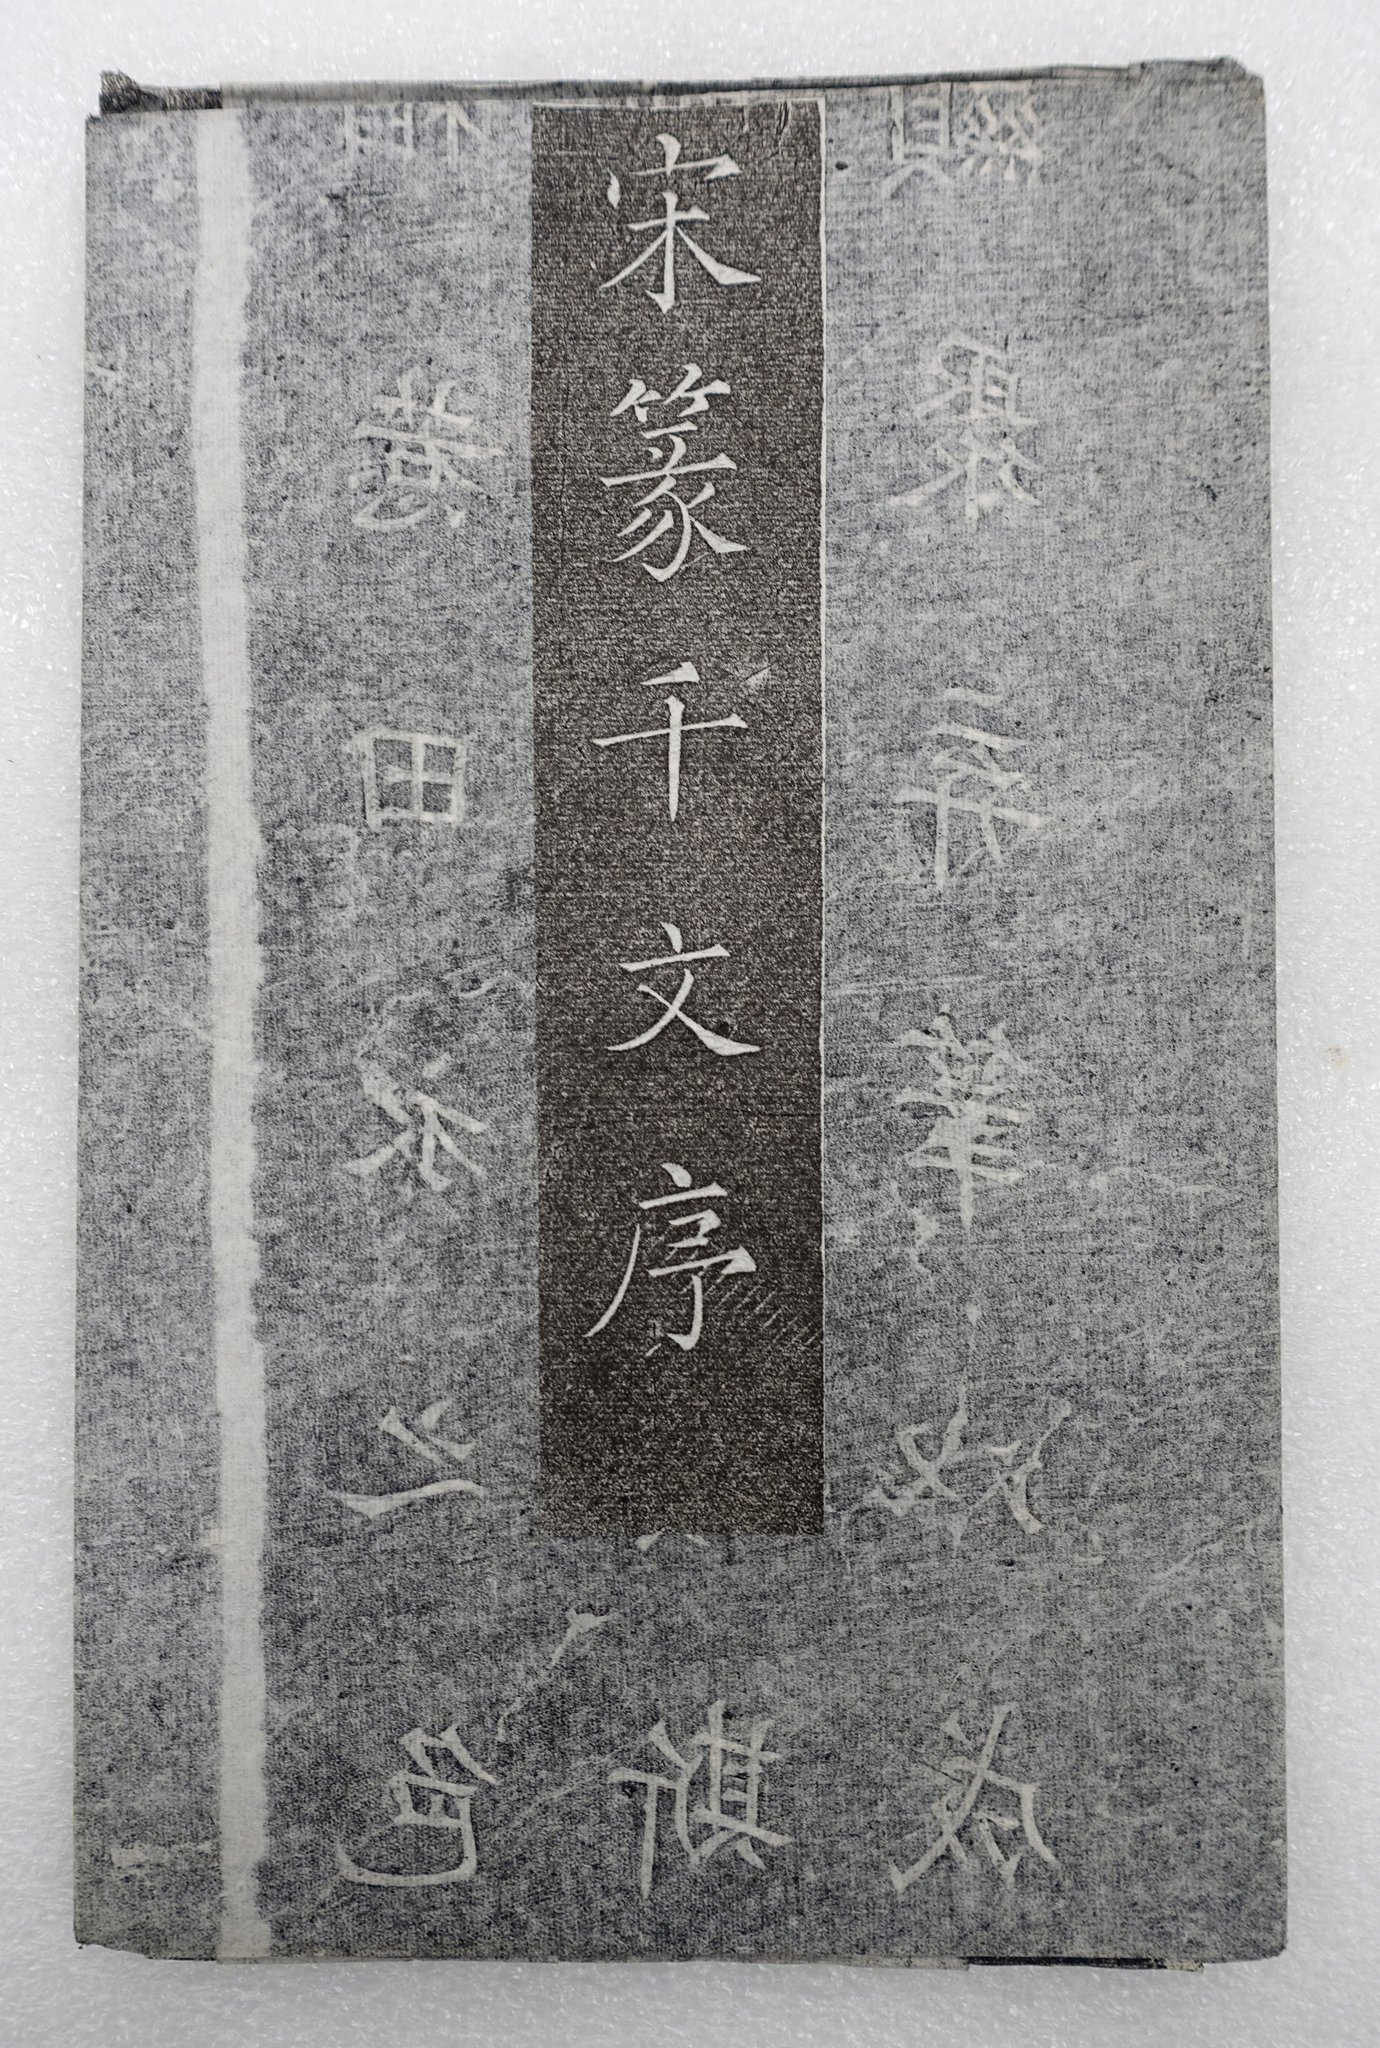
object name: rubbing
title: Preface to the Thousand-character Essay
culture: chinese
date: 1901-2000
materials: ink, paper